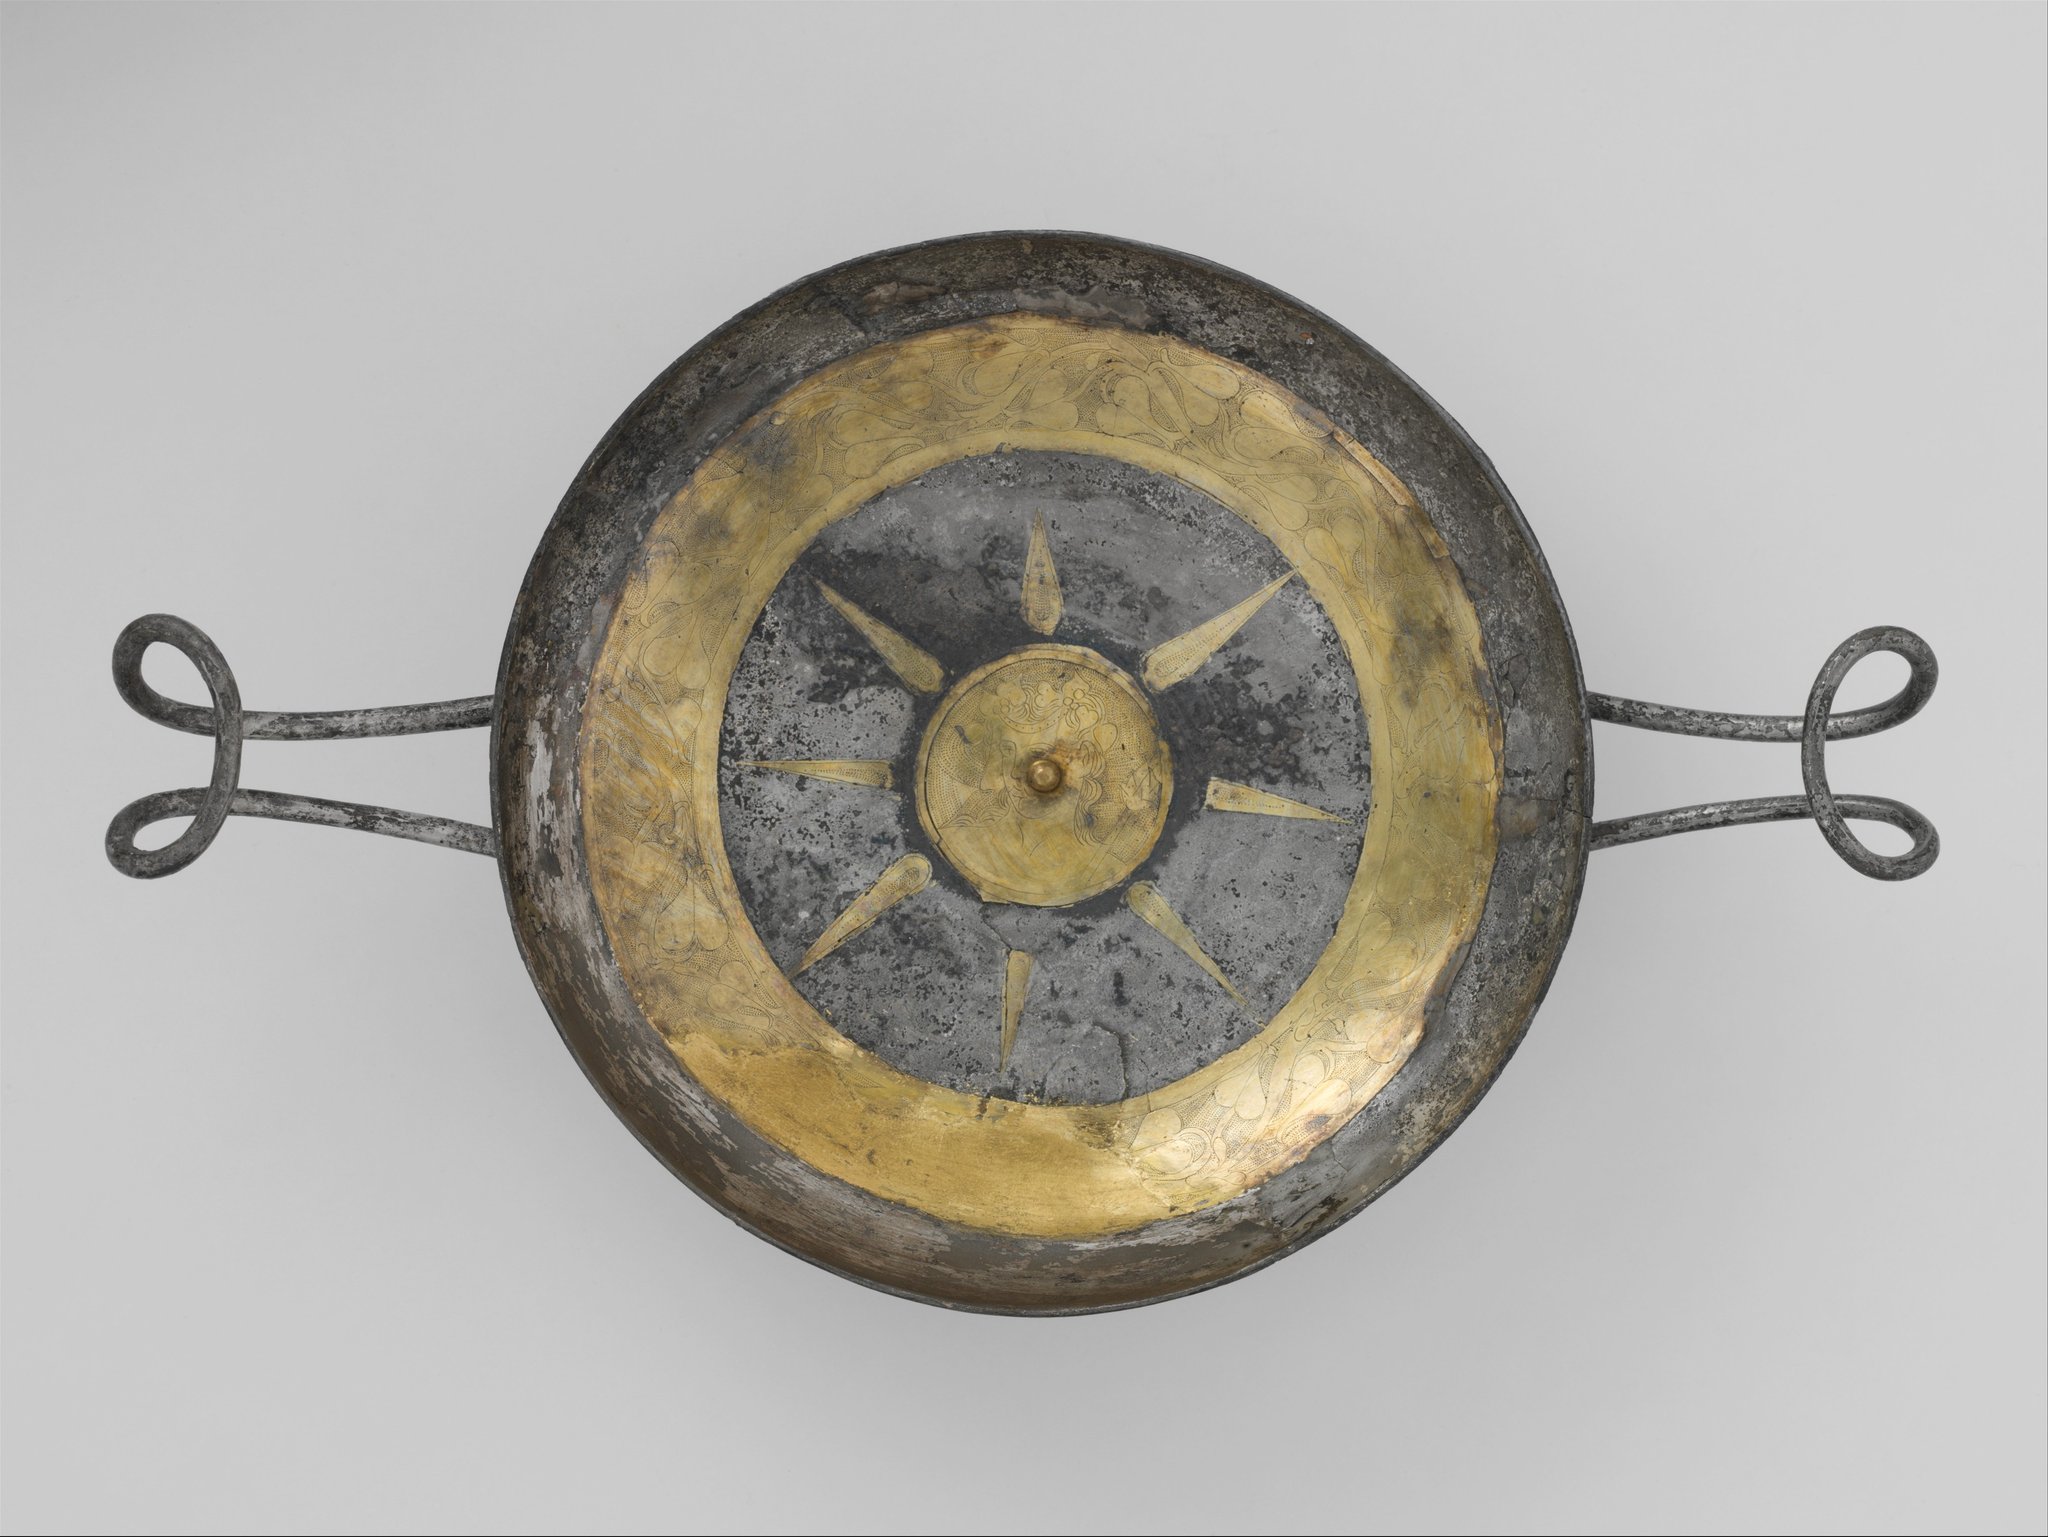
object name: cup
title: Silver-gilt cup (one of a pair)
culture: greek or south italian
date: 400-201 BCE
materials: gold, silver